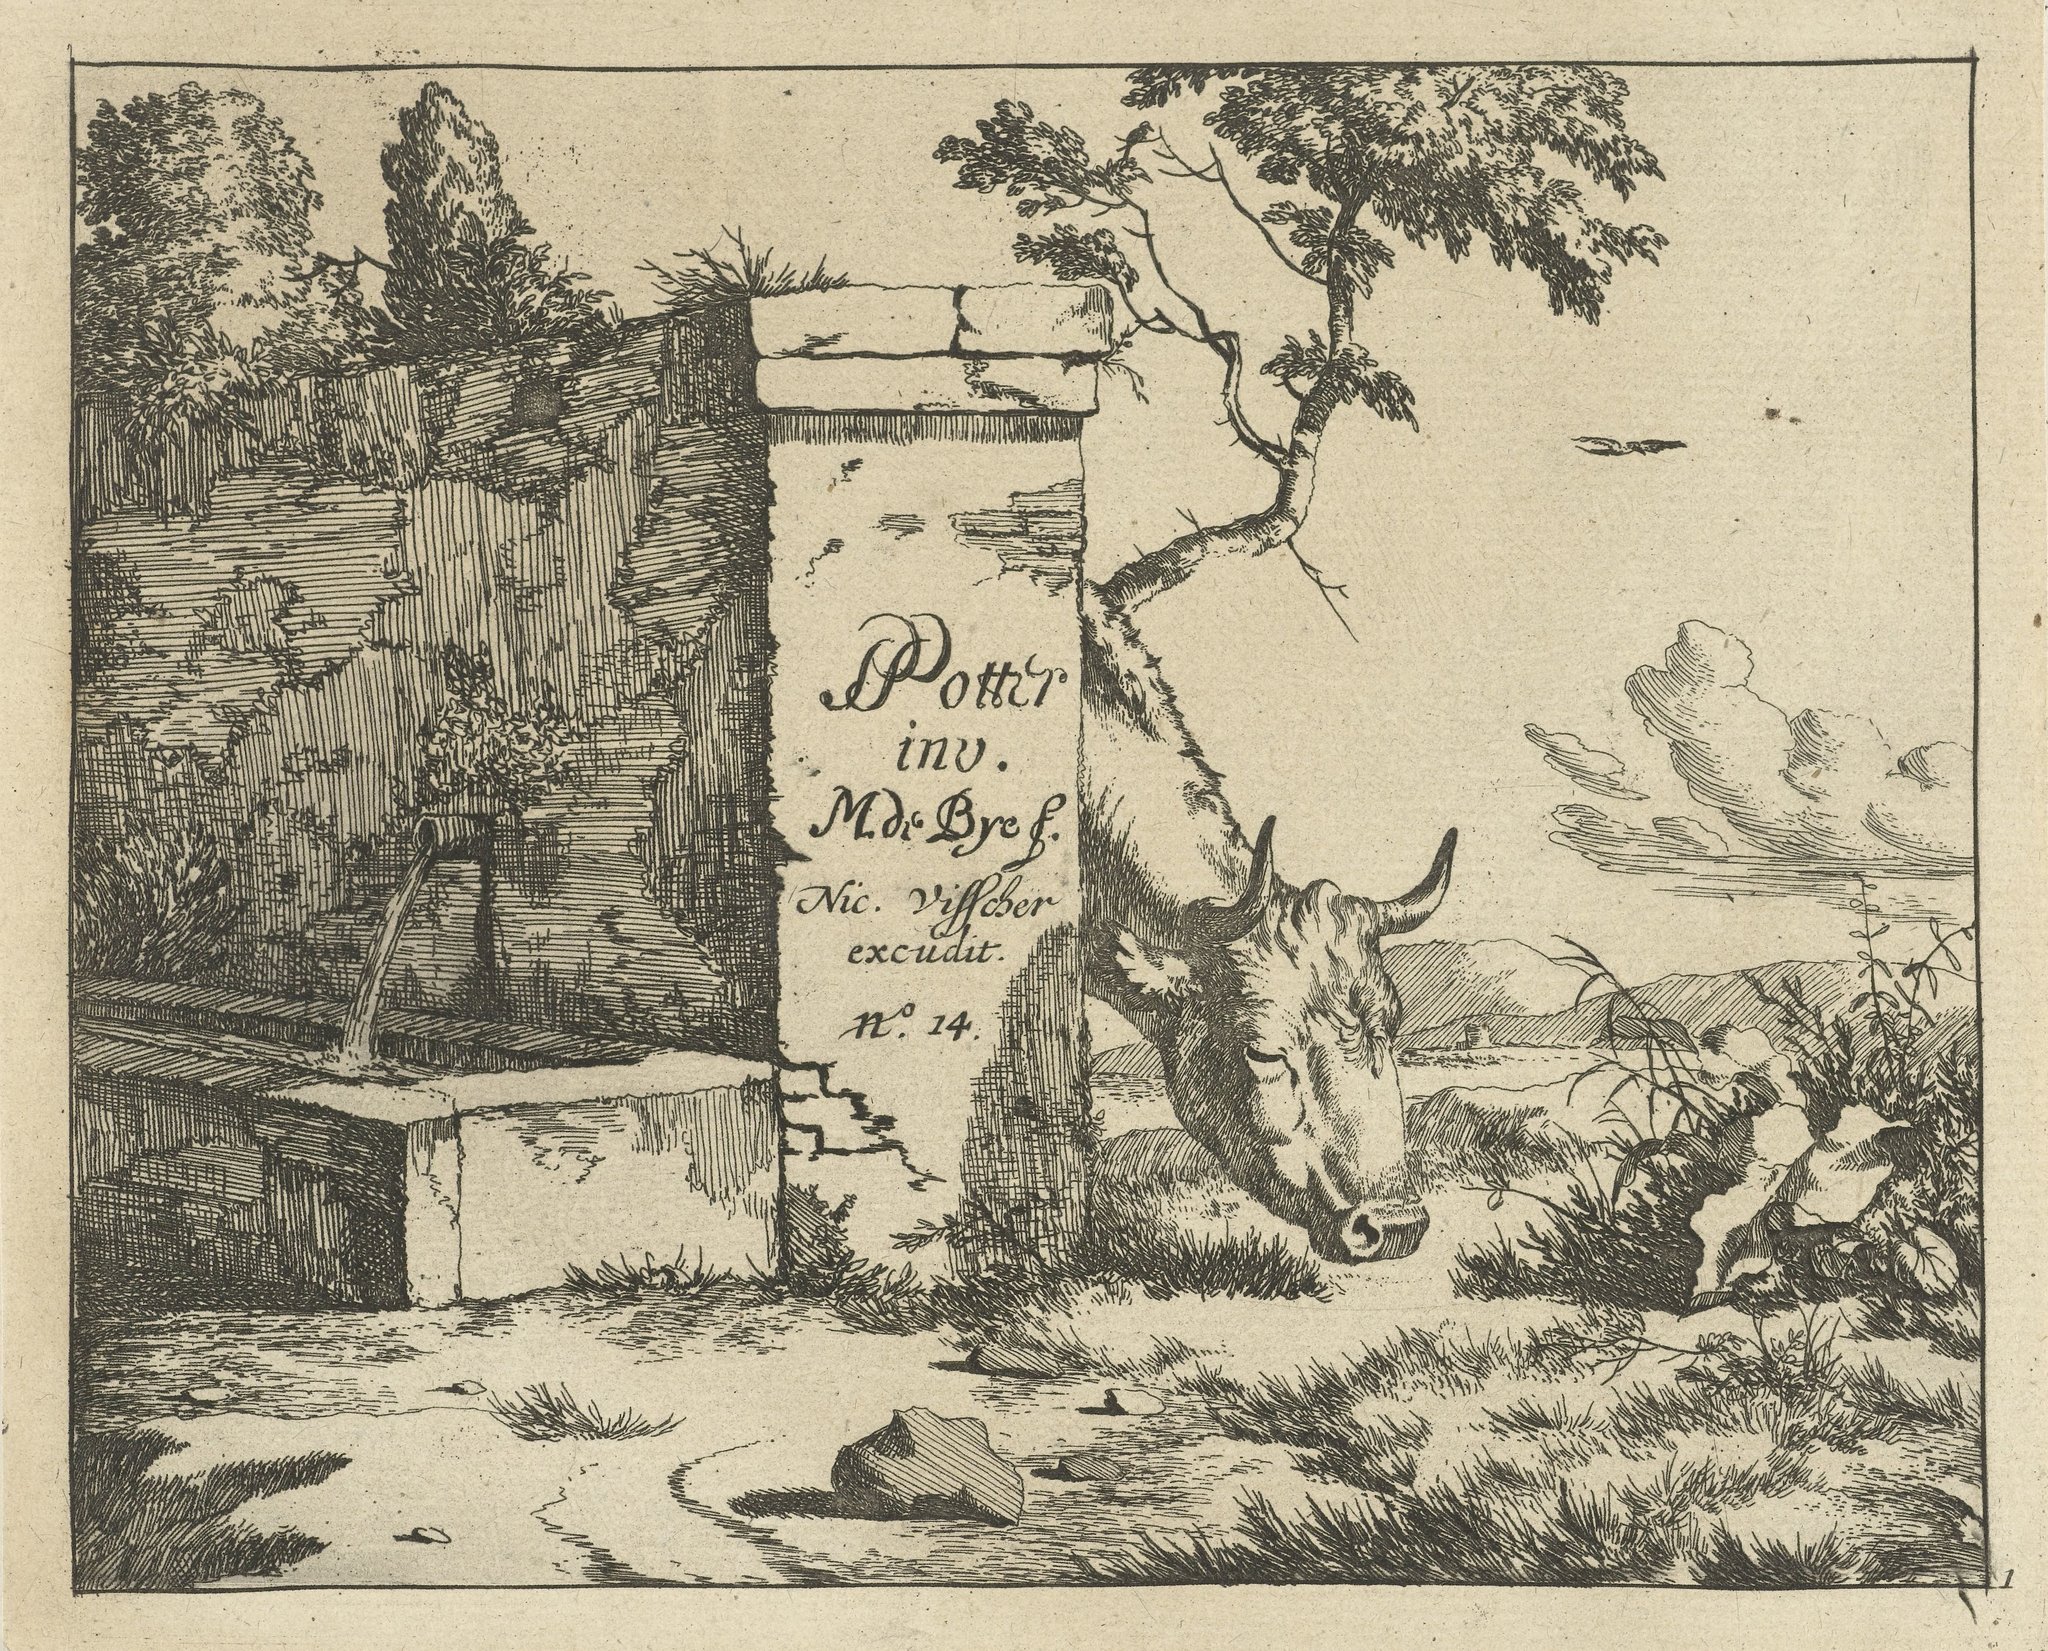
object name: titelprent, frontispice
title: Grazend rund achter muur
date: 1657-1677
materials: paper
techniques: etching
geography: amsterdam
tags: cow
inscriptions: collector's mark: Lugt 2228